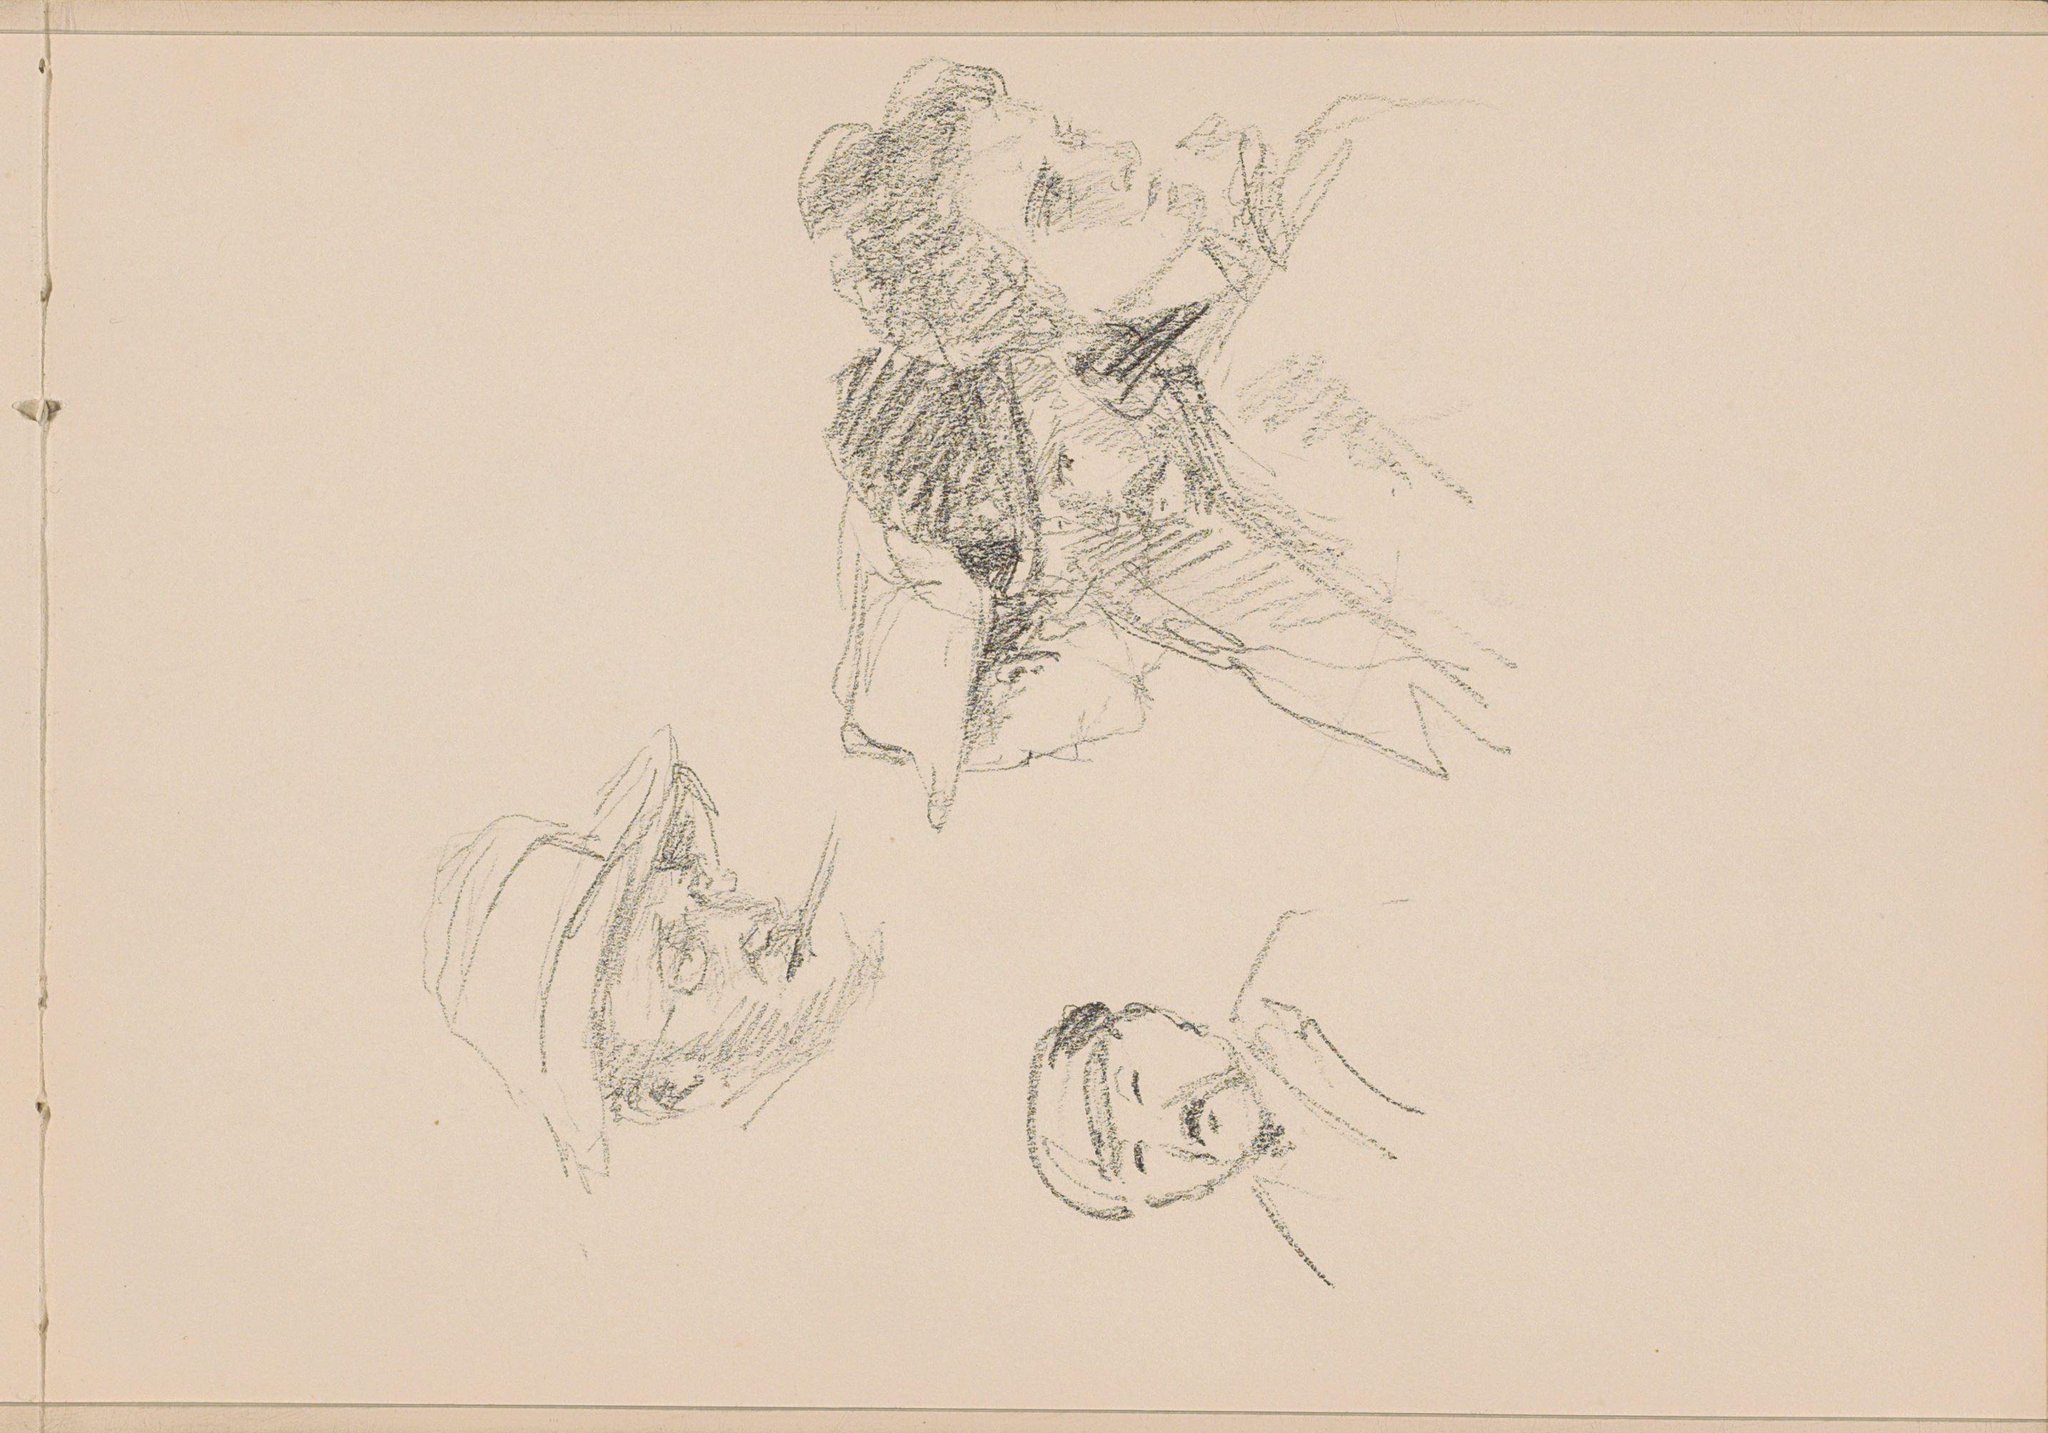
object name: sketchbook leaf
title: Figuurstudies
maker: a.a.l. de grammont-hubrecht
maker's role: draughtsman, painter, print maker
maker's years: 1855-1913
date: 1865-1913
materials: chalk, paper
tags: head (human), adult woman, adult man, pipe ~ tobacco, head-gear: hat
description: De mannen dragen verschillende hoofddeksels. Blad 55 recto uit een schetsboek met 68 bladen.